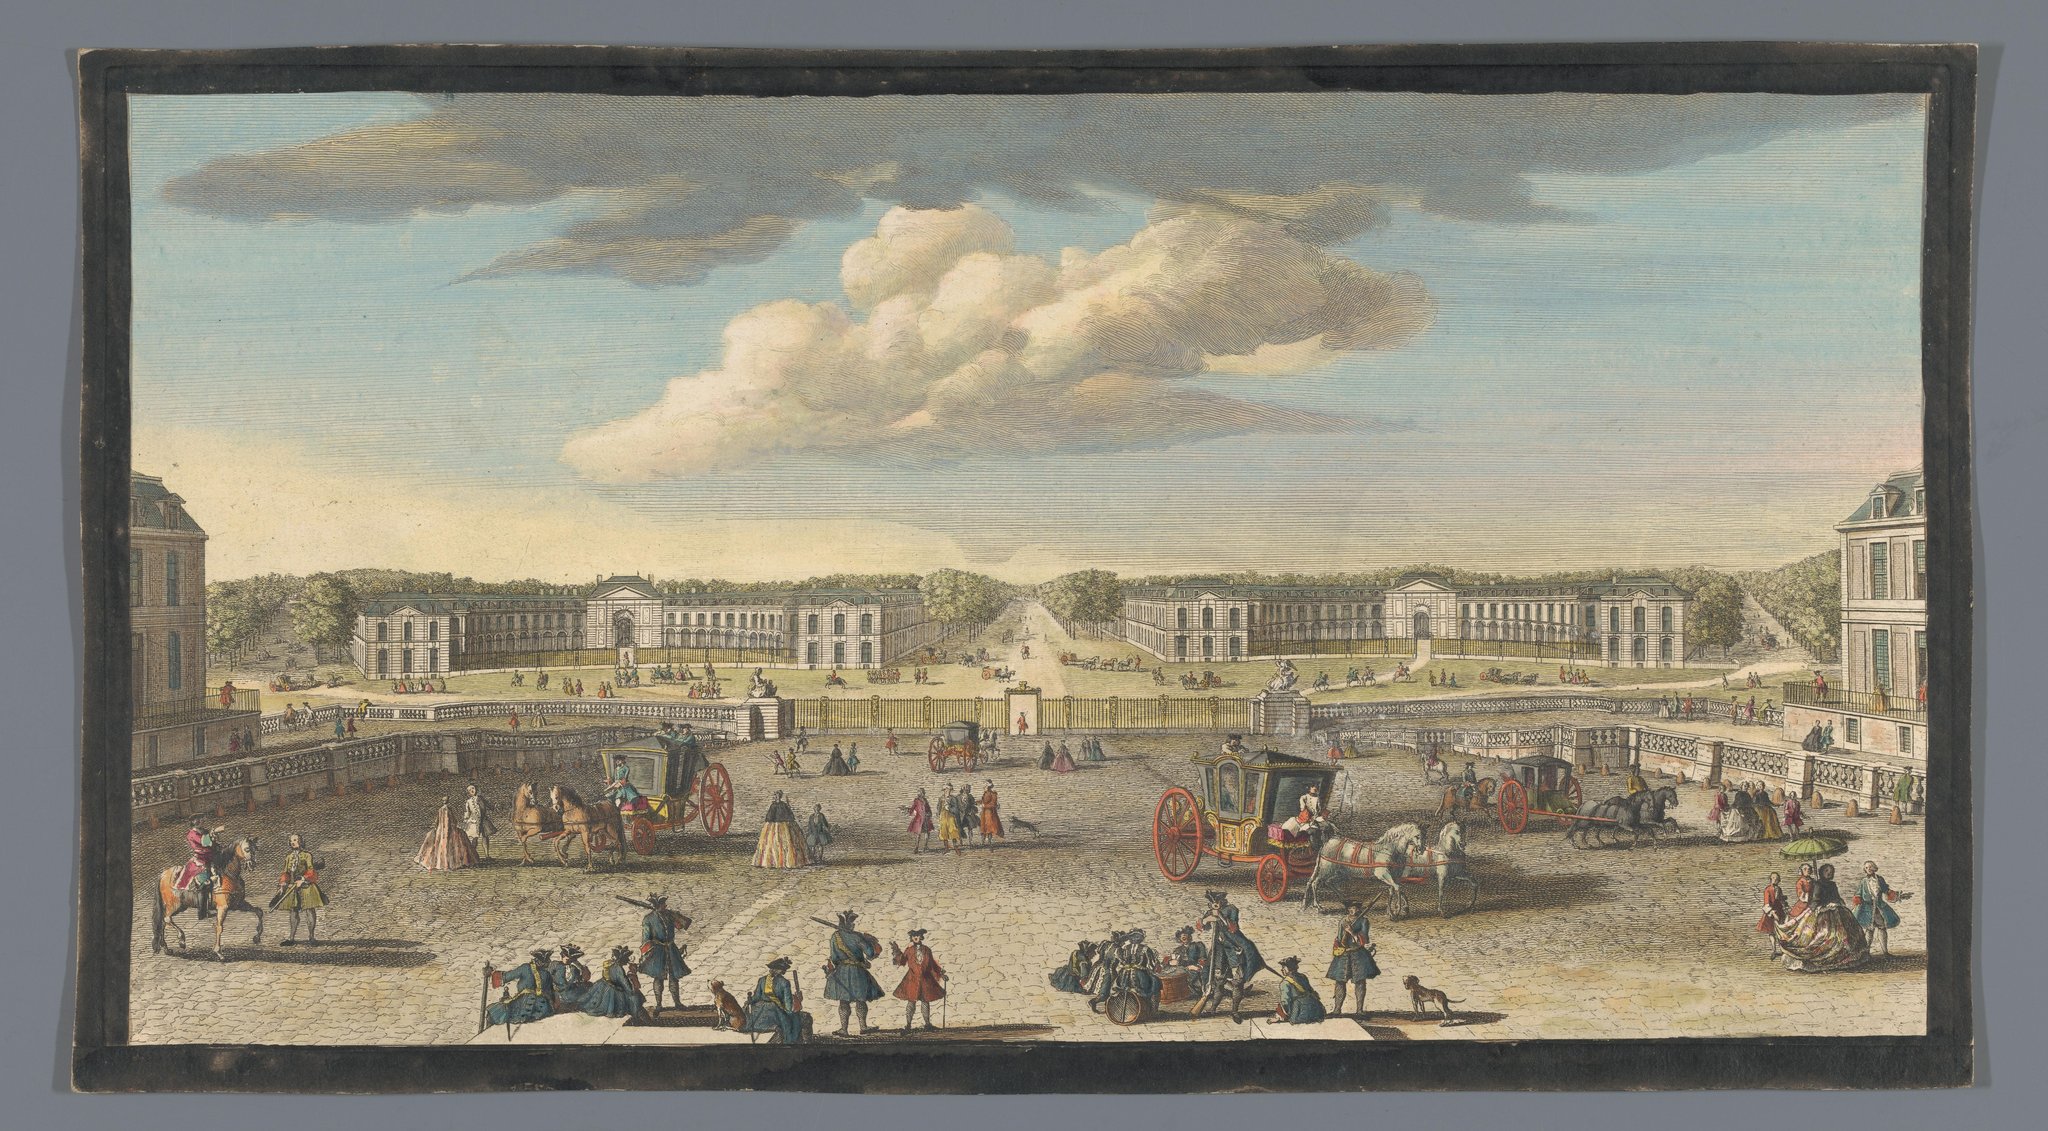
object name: print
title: Gezicht op de stallen van het Paleis van Versailles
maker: Anonymous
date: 1700-1799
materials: cardboard, paper, watercolor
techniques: brush, etching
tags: animal traction, animal-drawn vehicle (carriage etc.), palace, stall, stable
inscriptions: inscription: ‘Fo 8 B4’